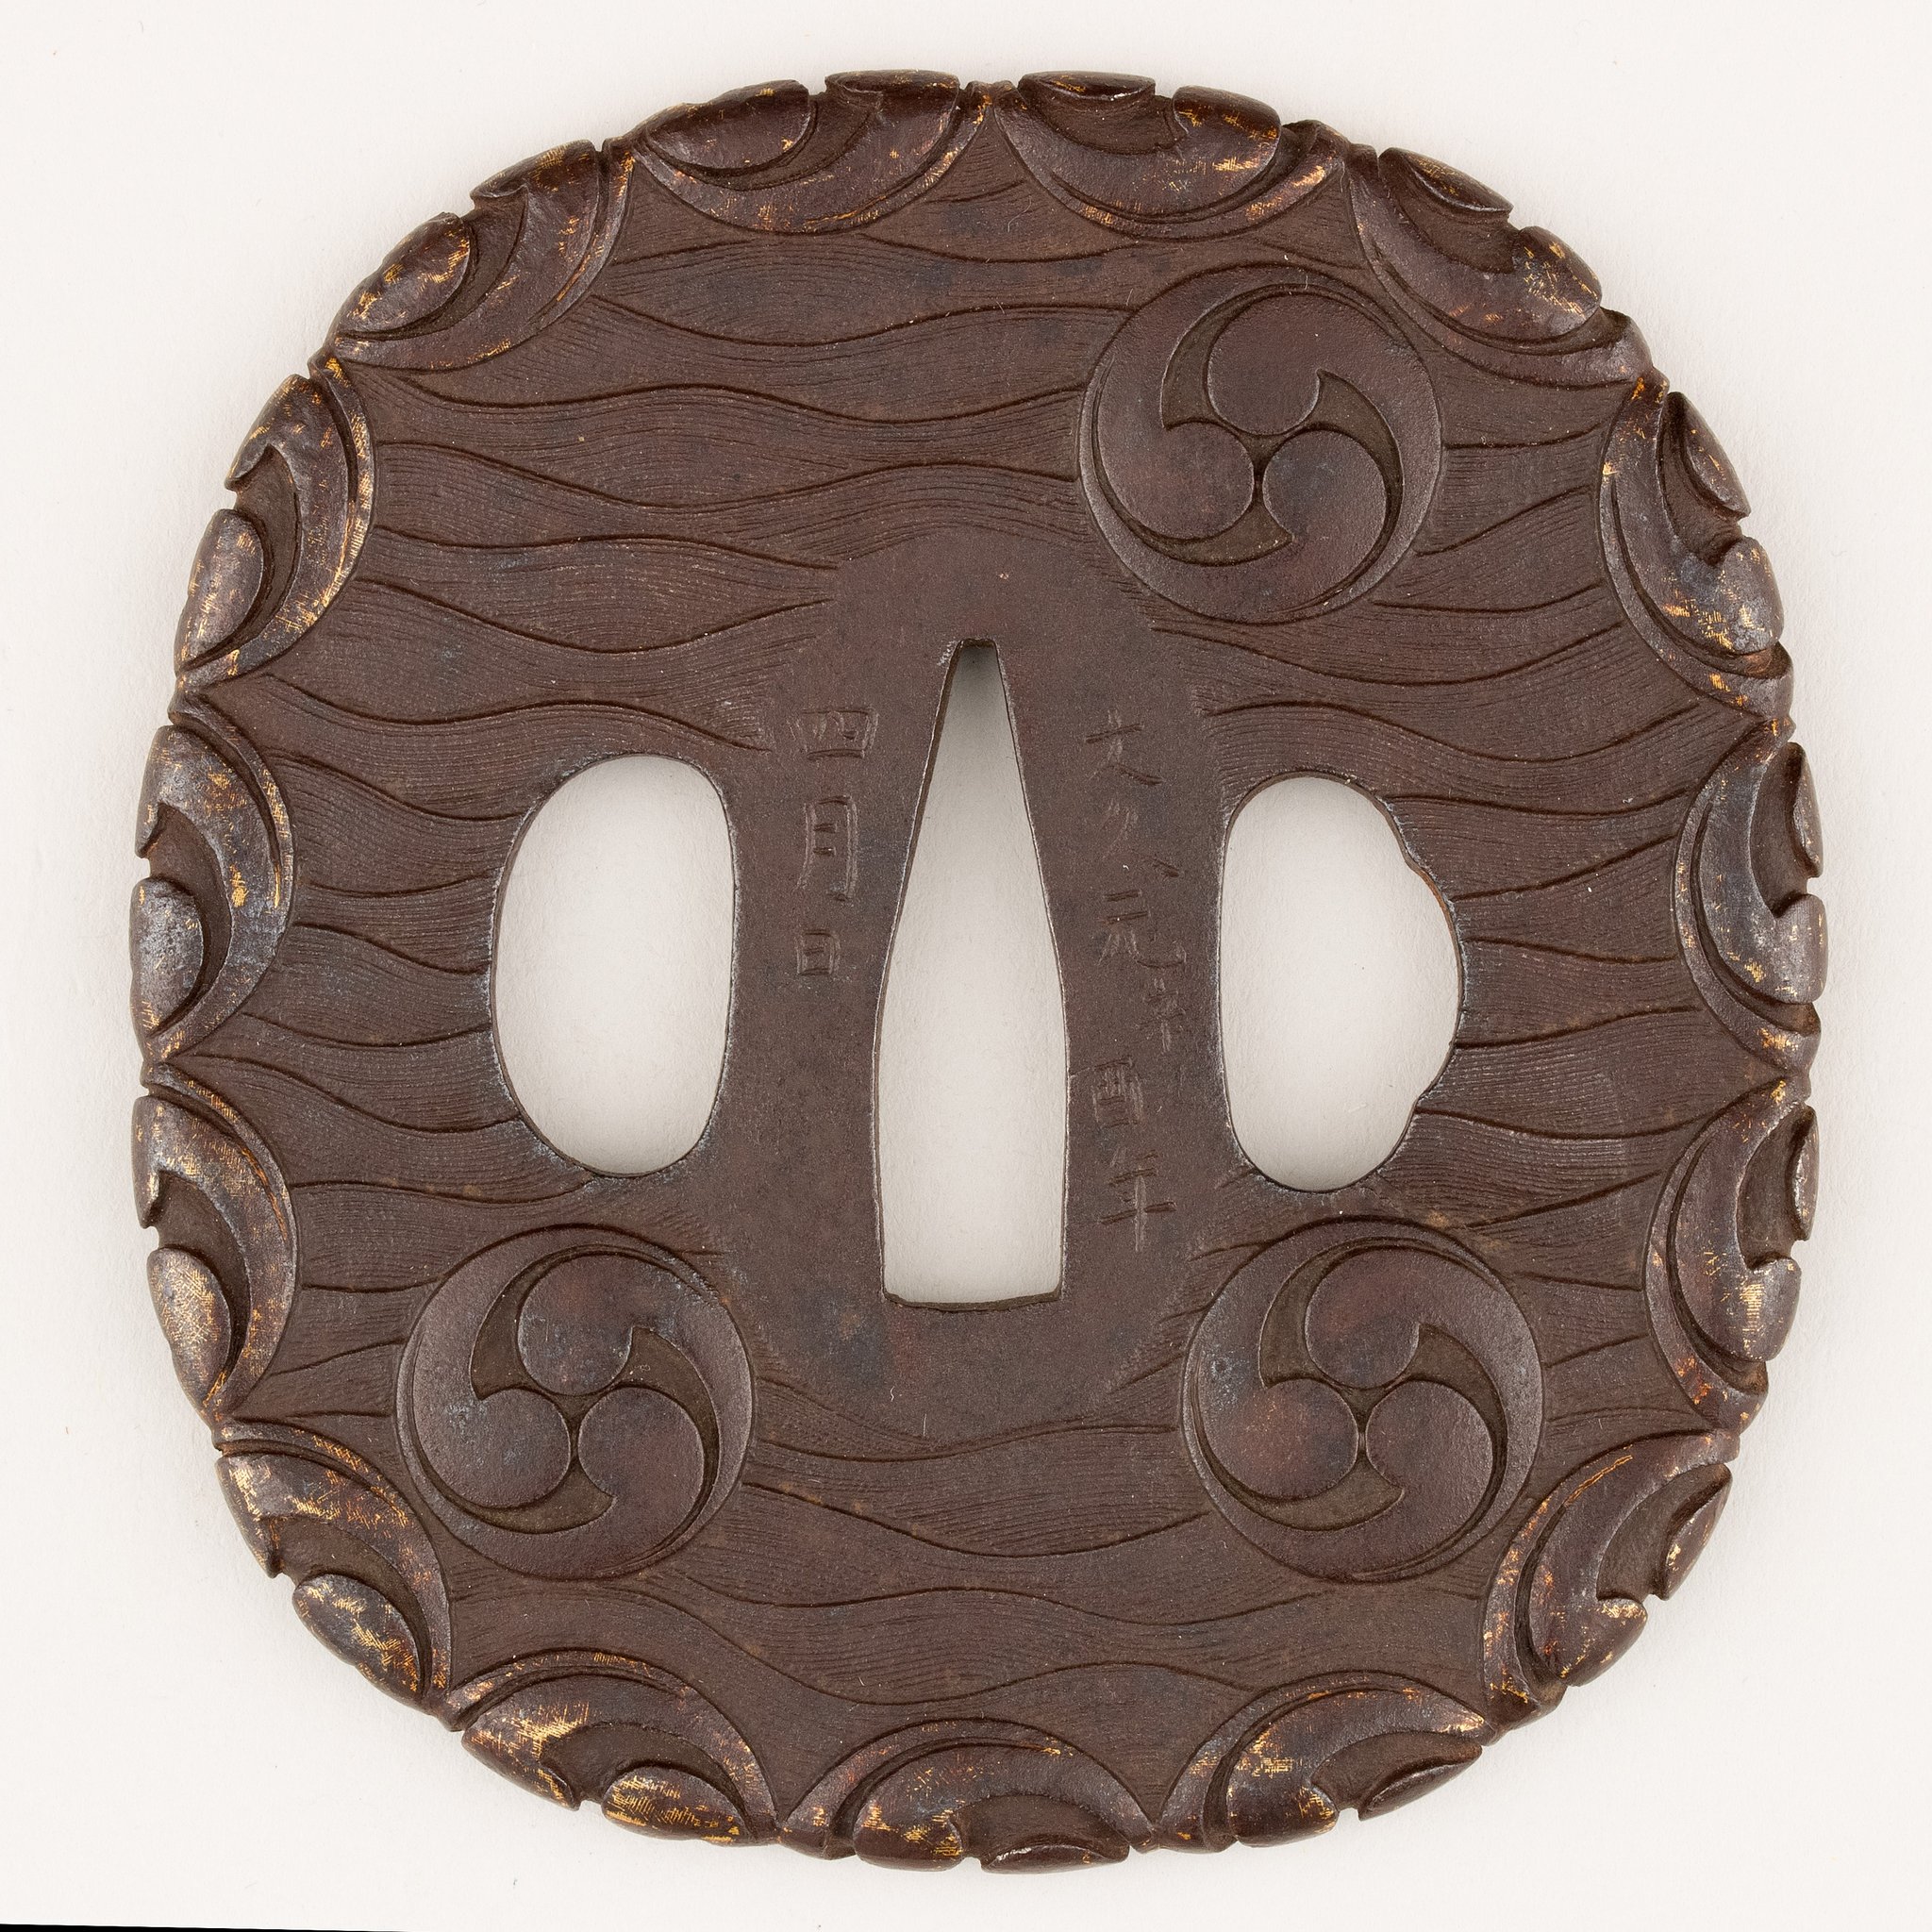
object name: sword guard tsuba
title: Sword Guard (Tsuba)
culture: japanese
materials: iron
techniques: gilding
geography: japan